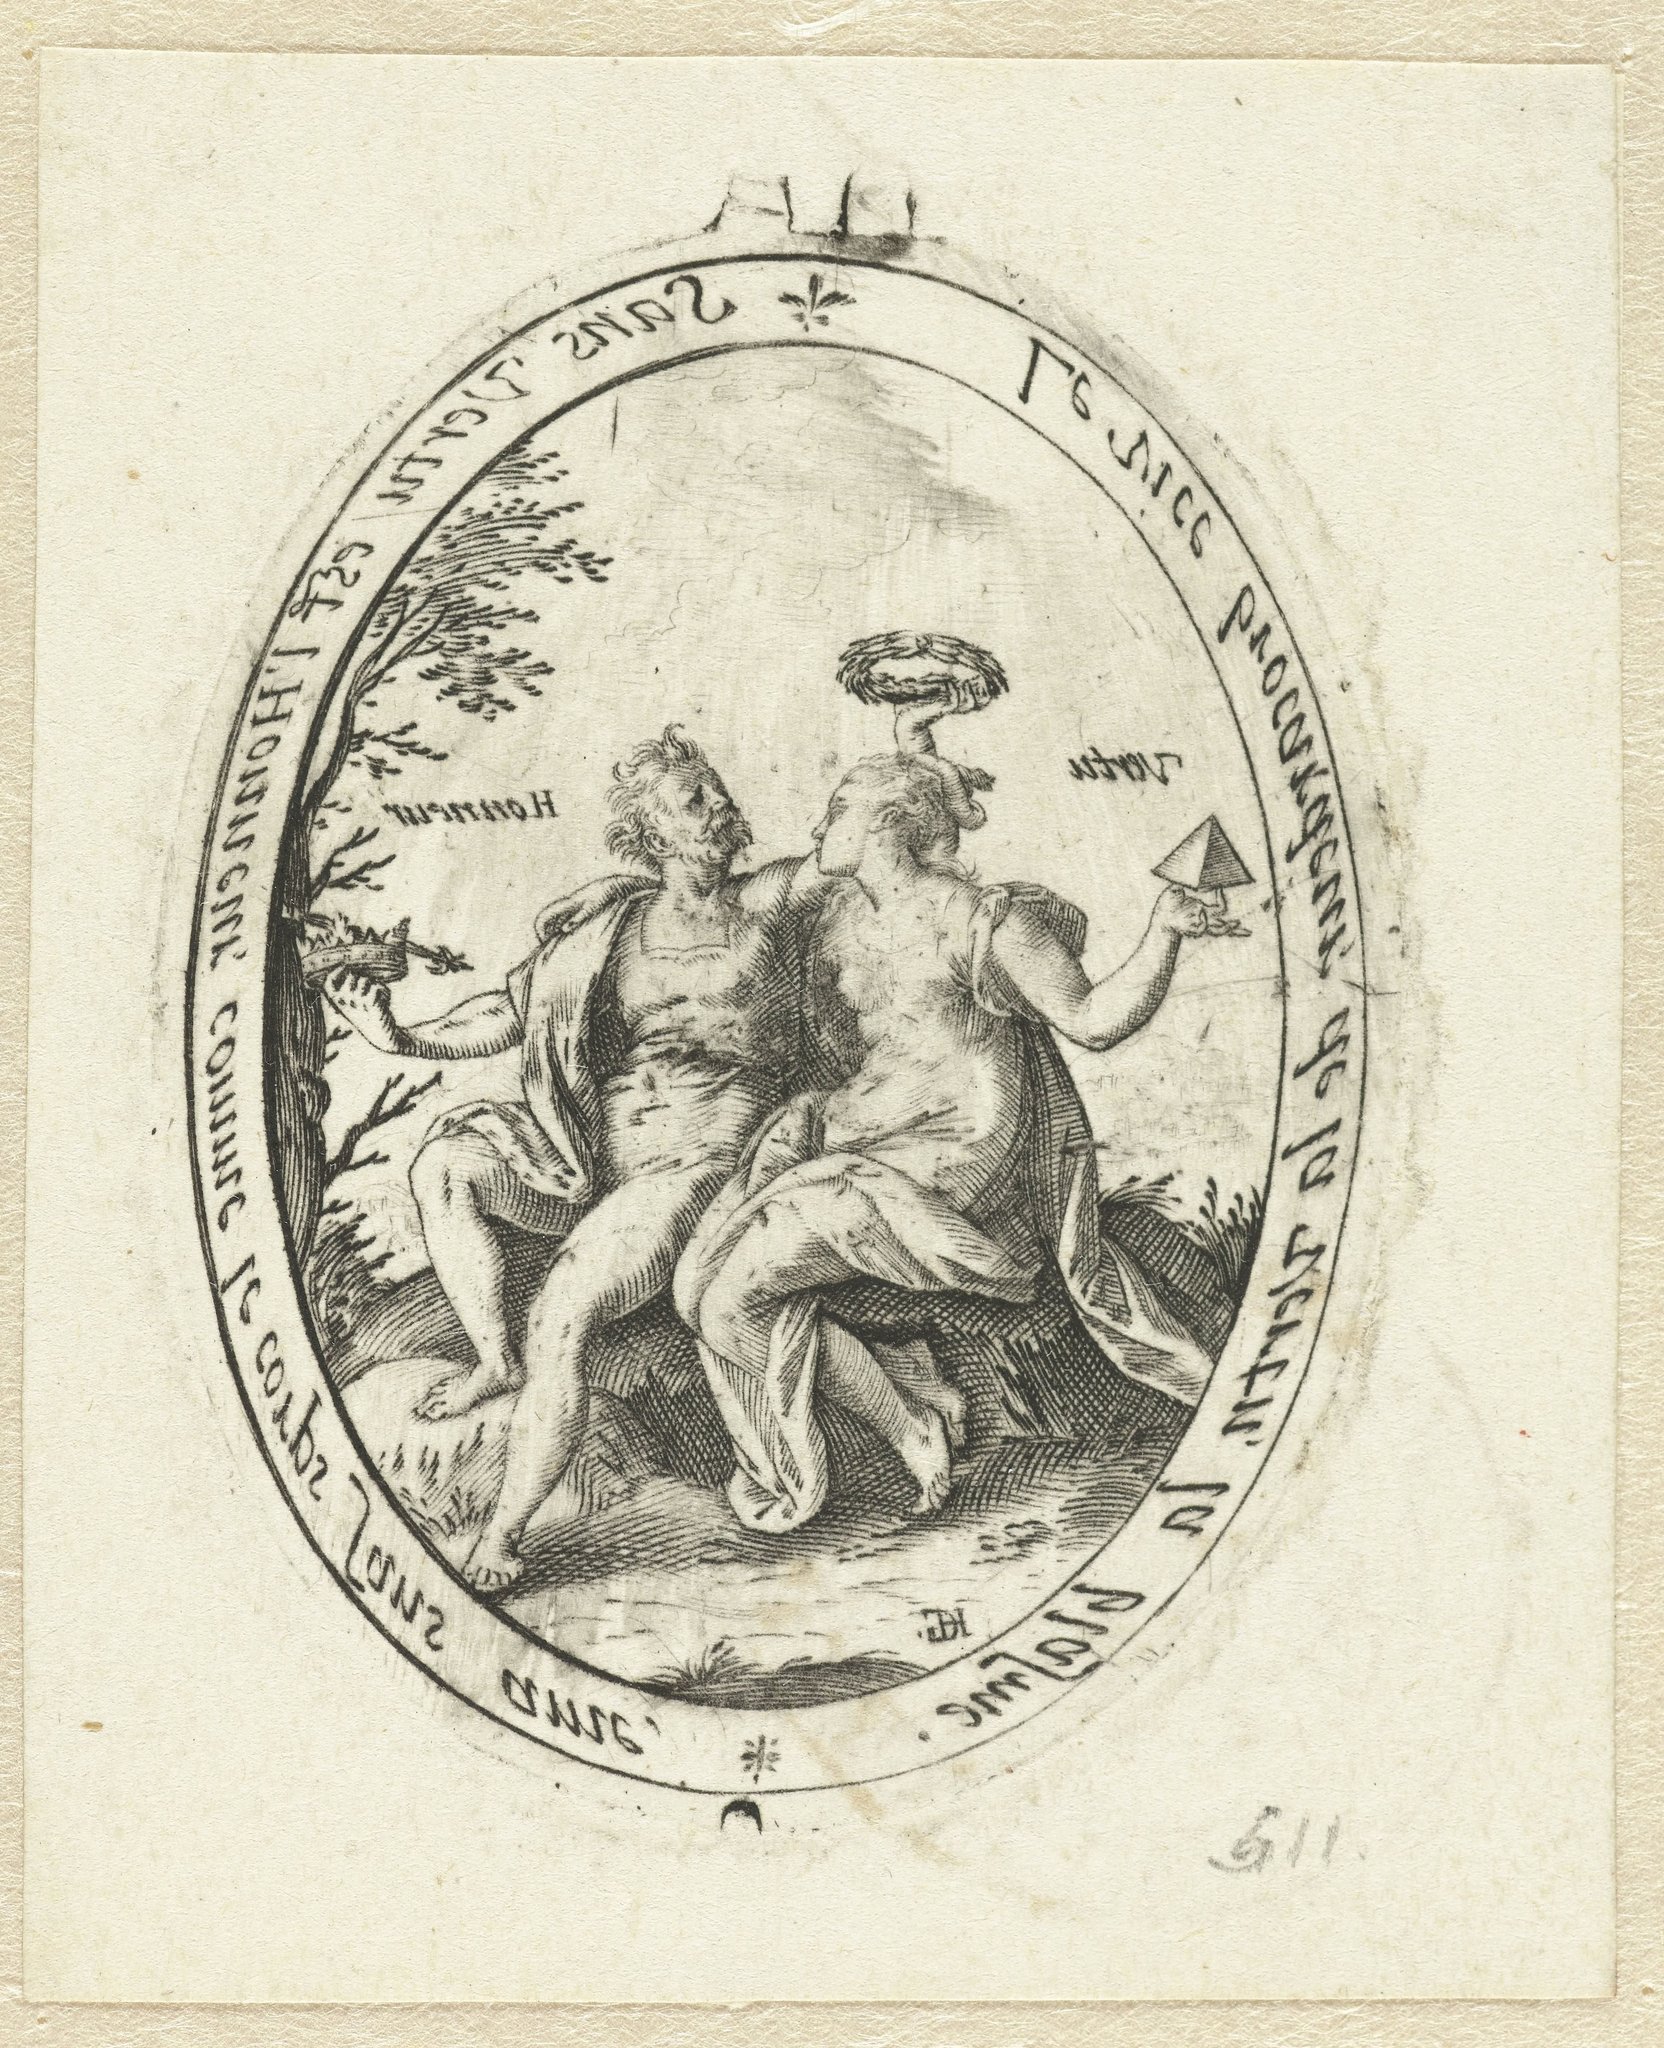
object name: print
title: Deugd en Eer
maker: hendrick goltzius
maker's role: draughtsman, painter, print maker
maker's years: 1558-1617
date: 1584-1588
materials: paper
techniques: engraving, etching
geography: haarlem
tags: honour, 'honor' ~ one of the seven gifts of the soul, virtuousness; 'amor di virtù', 'attione virtuosa', 'guida sicura de' veri honori', 'virtù', 'virtù insuperabile' (ripa)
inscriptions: collector's mark: Lugt 240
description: Ovale voorstelling van Deugd en Eer, in de gedaanten van een vrouw met een piramide en een man met een kroon. Om de voorstelling een randschrift in het Frans in spiegelbeeld. Deze prent heeft als pendant een ovale emblematische voorstelling. Beide zijn waarschijnlijk gedrukt van voor- en achterzijde van één medaillon.